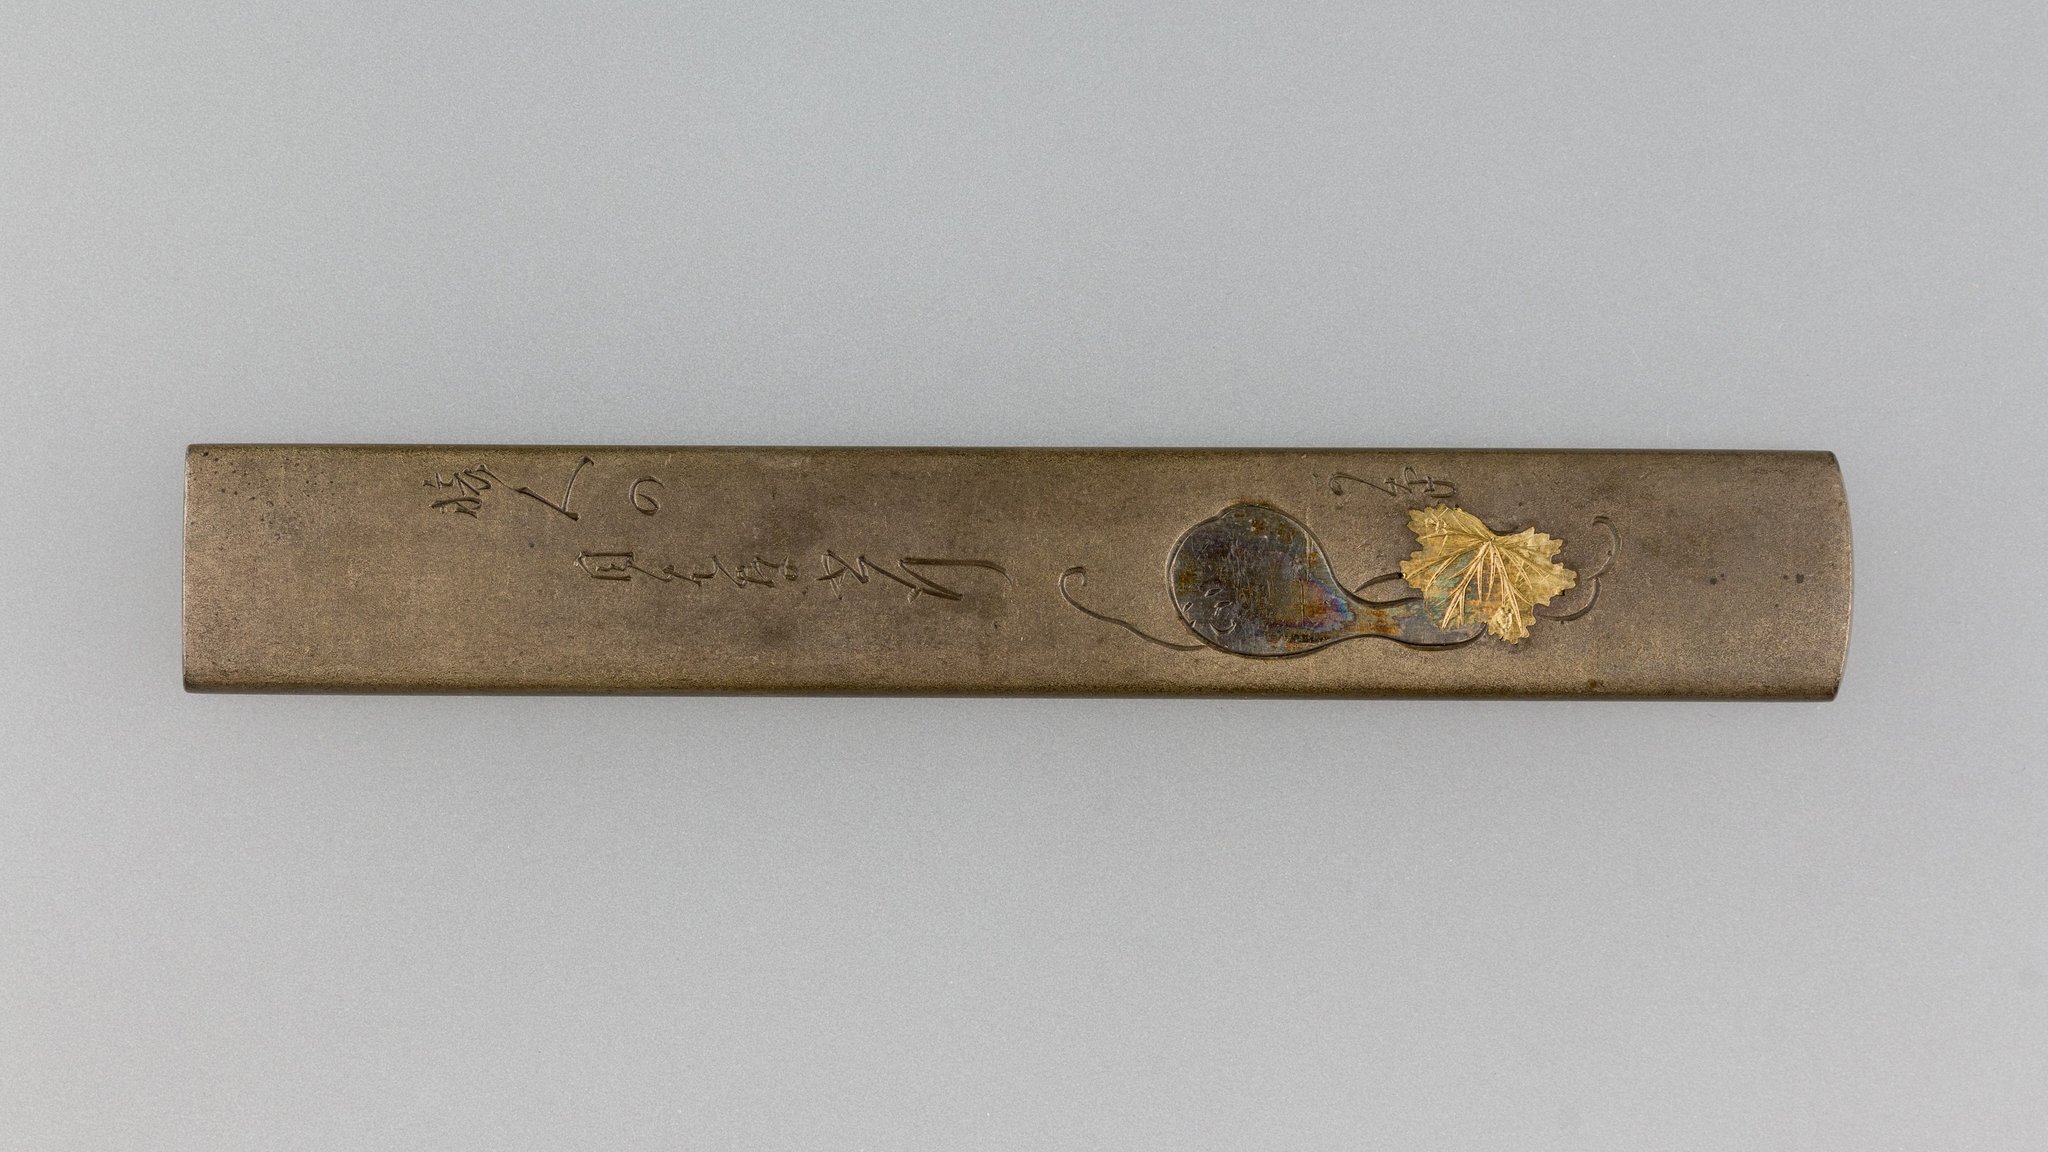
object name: knife handle kozuka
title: Knife Handle (Kozuka)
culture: japanese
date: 1789-1876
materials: silver alloy, gold, silver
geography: japan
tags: gourds